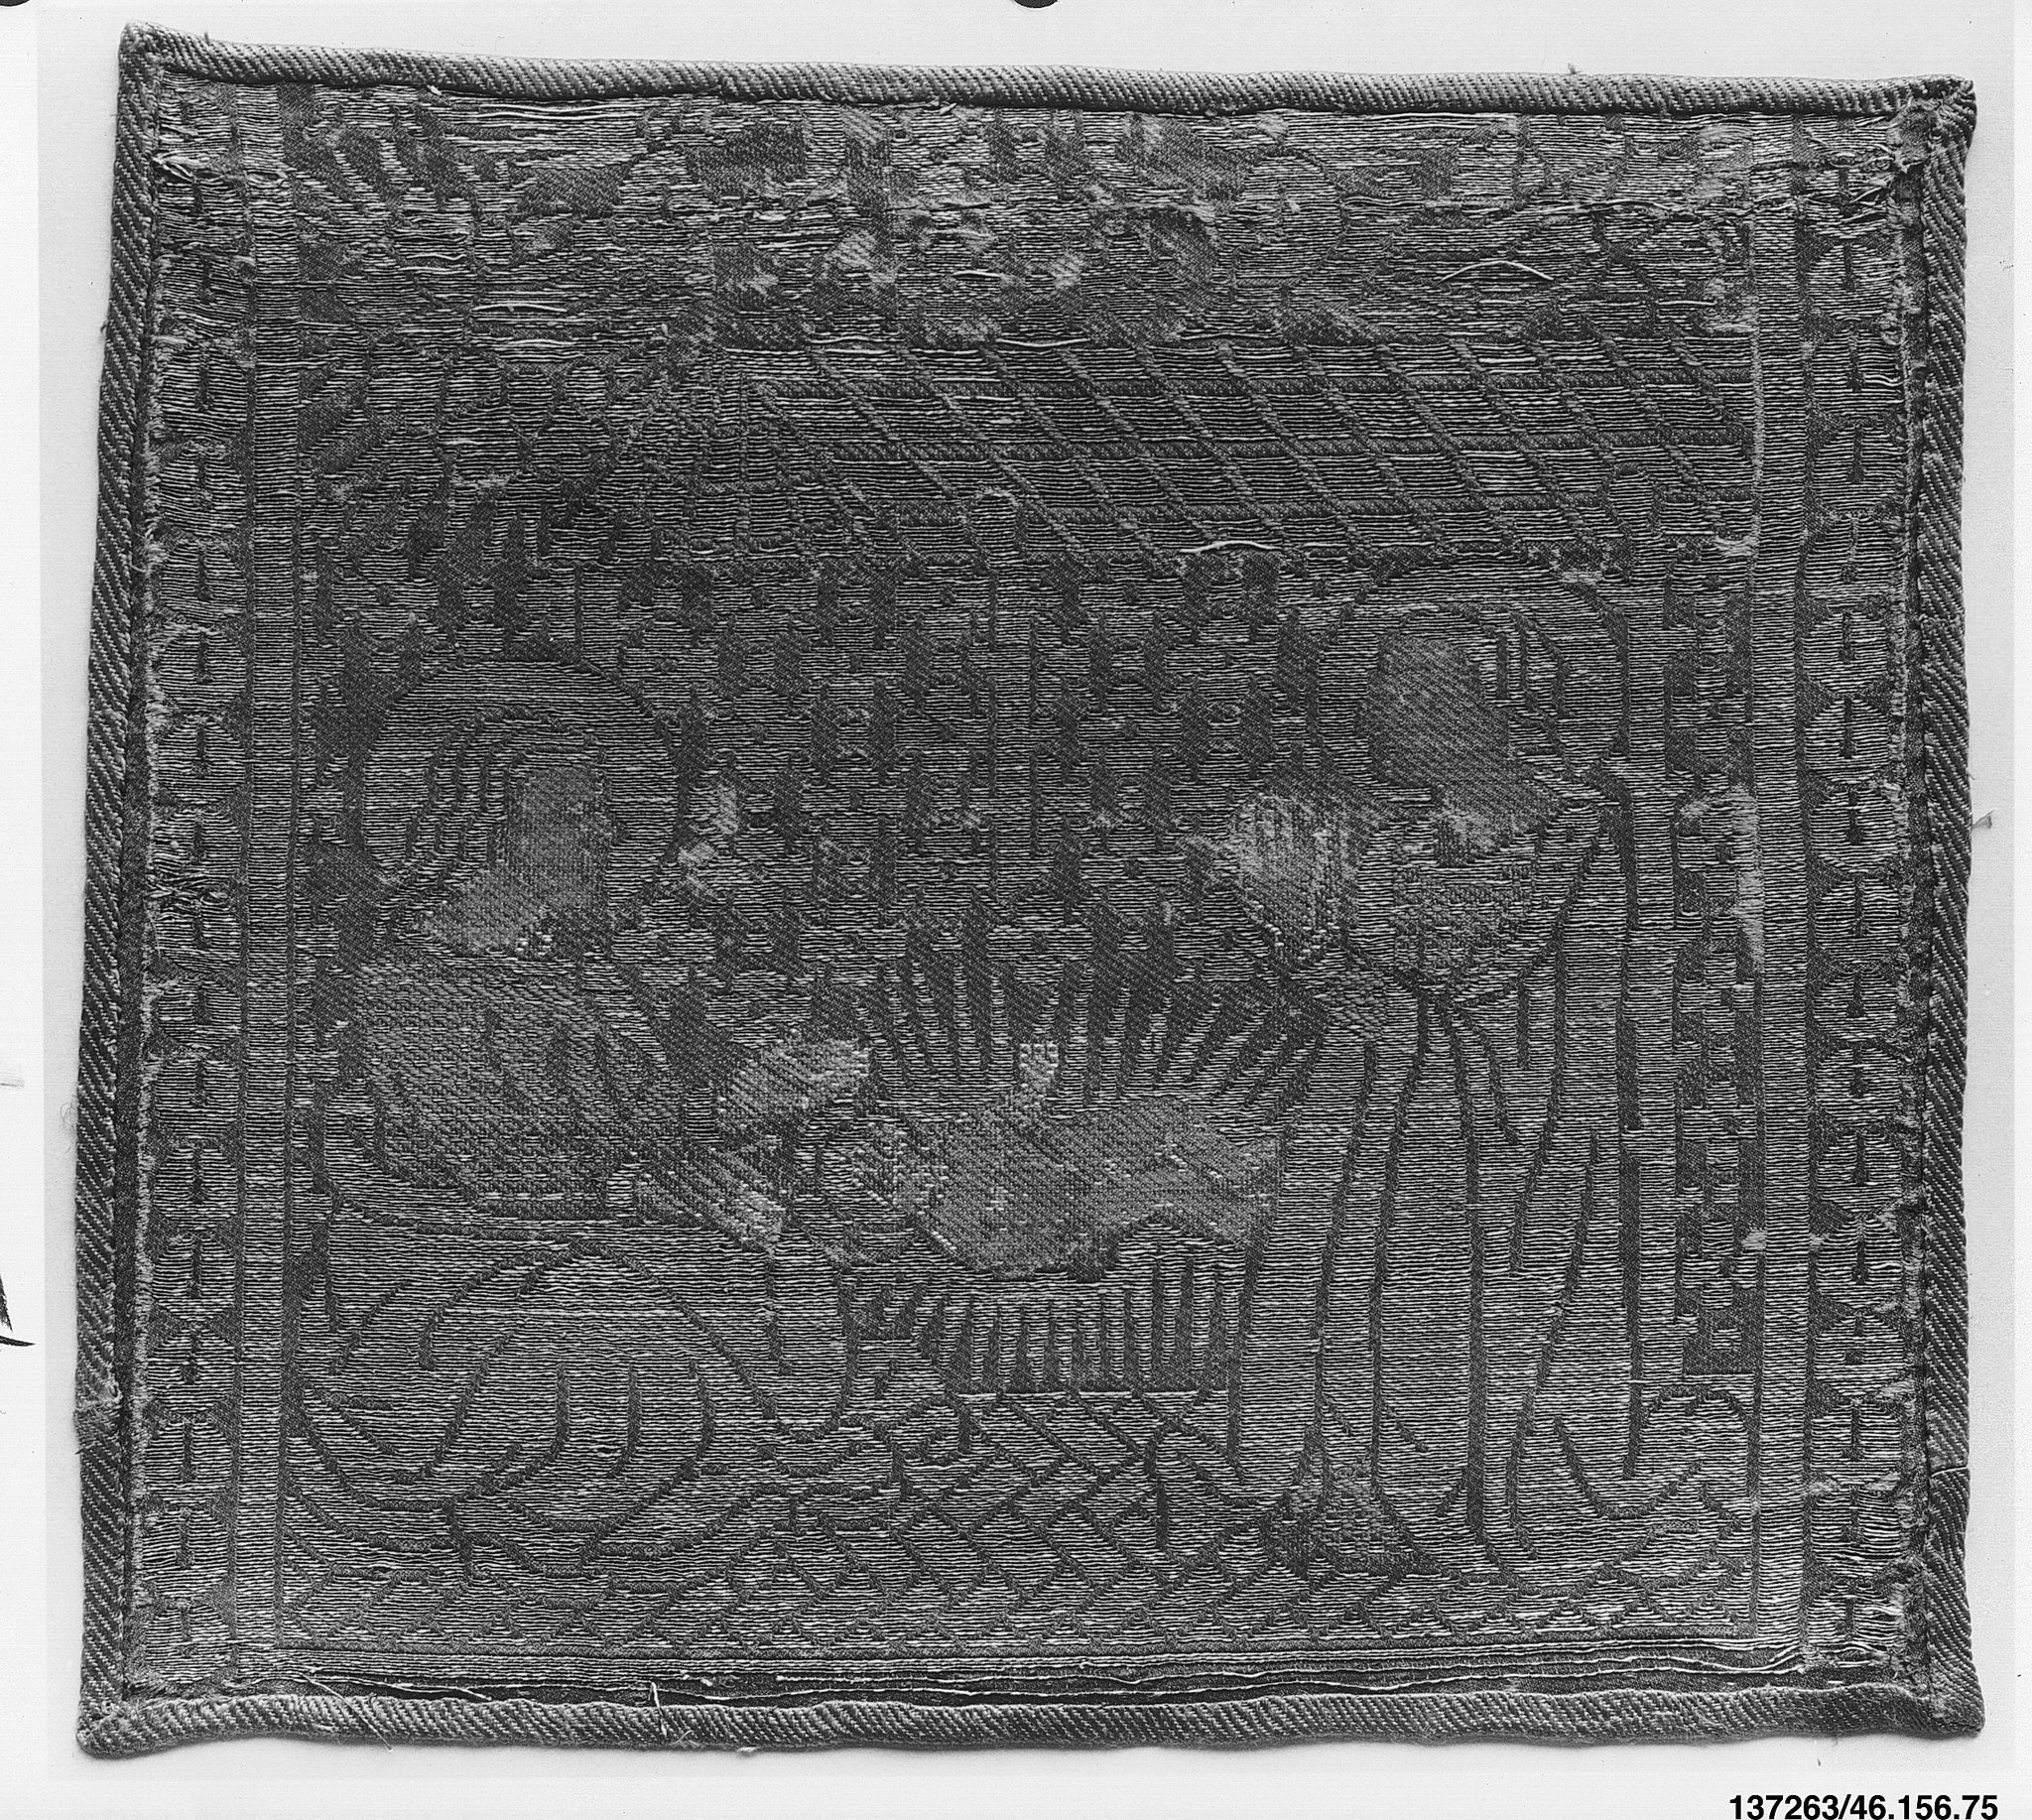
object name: orphrey fragment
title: Part of an orphrey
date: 1551-1600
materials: metal thread, silk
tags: nativity